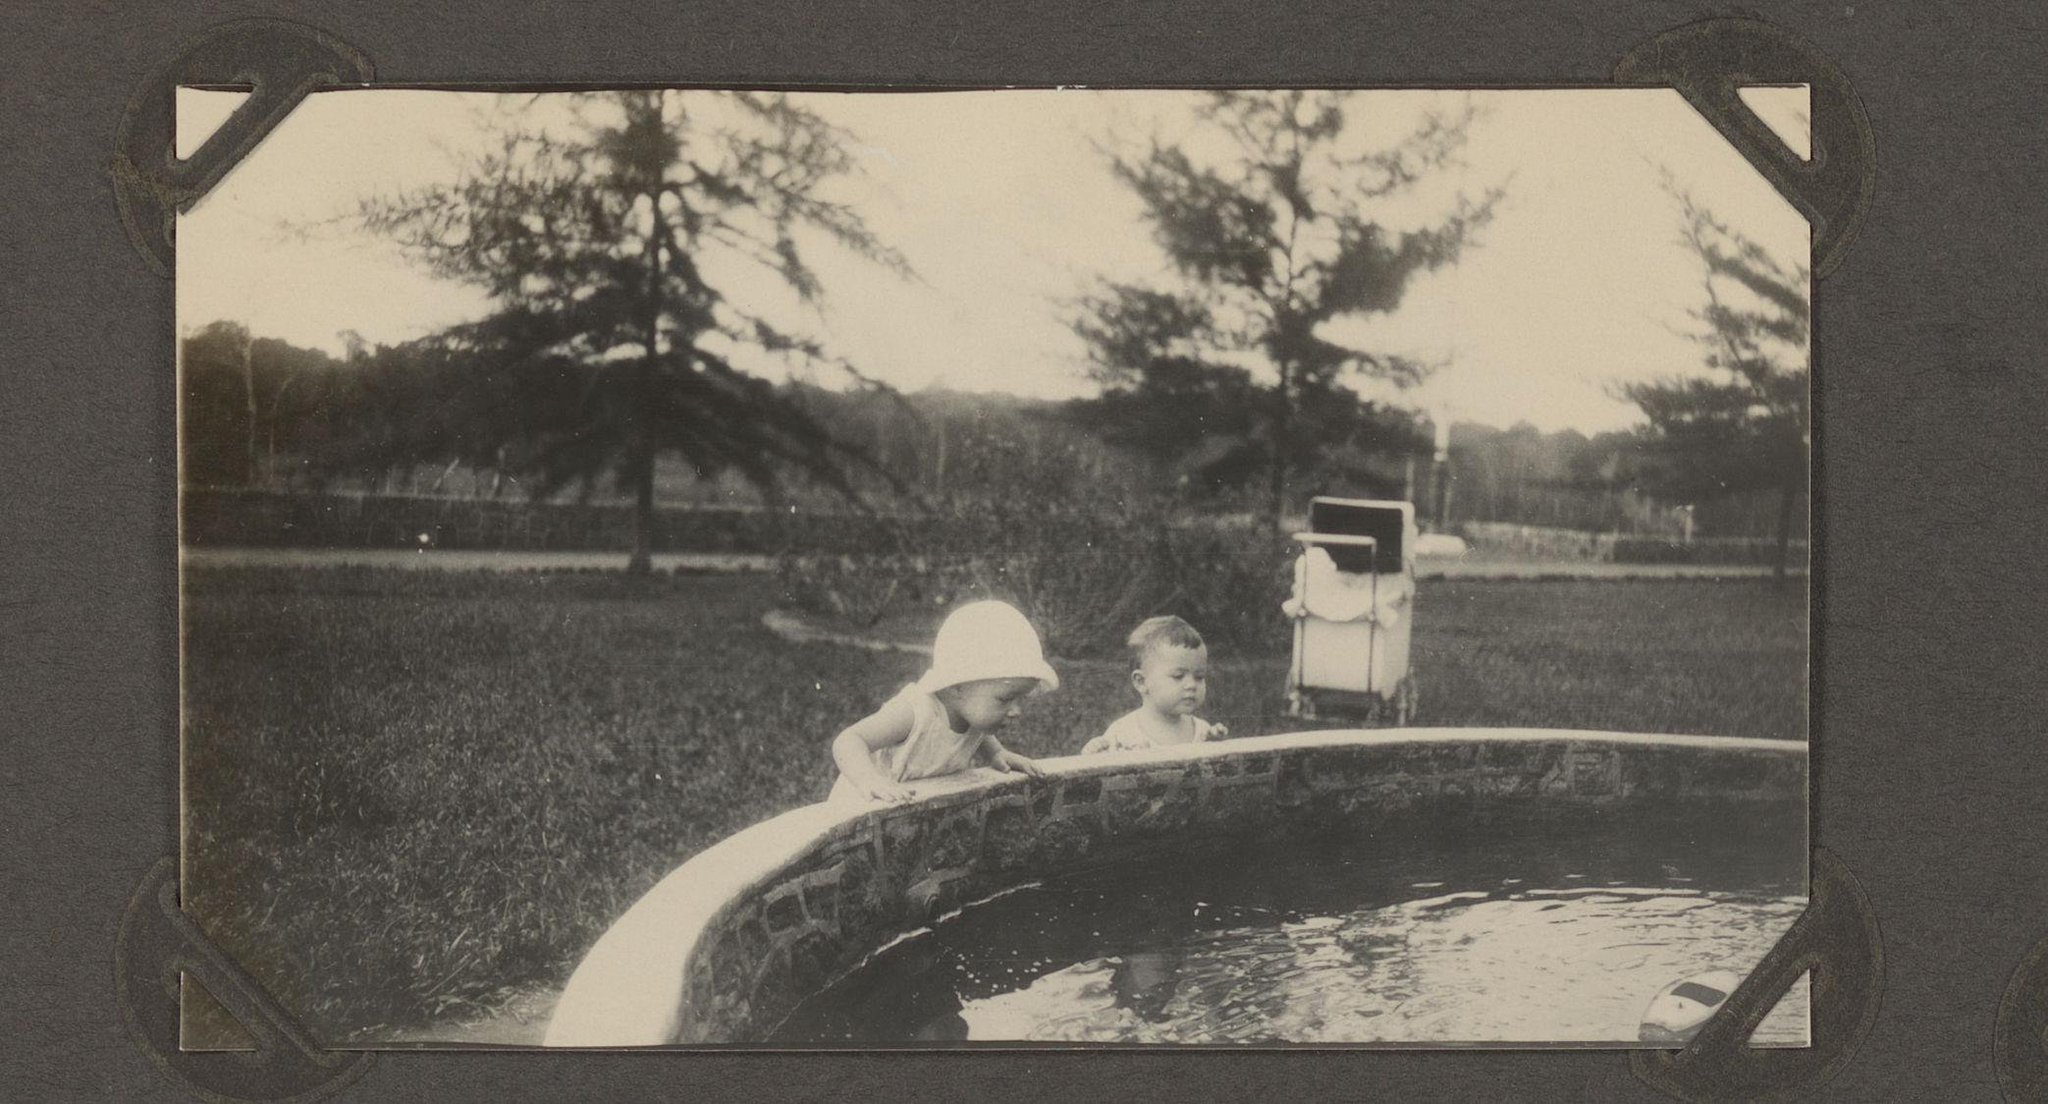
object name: photograph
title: Familiefoto van de kinderen Jetten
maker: Anonymous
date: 1925-1927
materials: photographic support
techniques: photography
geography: suriname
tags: jetten, familie, moengo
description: Familiefoto van de kinderen Jetten. Foto op een bladzijde van een los albumblad. Onderdeel van het ensemble met foto's van de familie van ingenieur Jetten in de mijnbouwstad Moengo in Suriname.